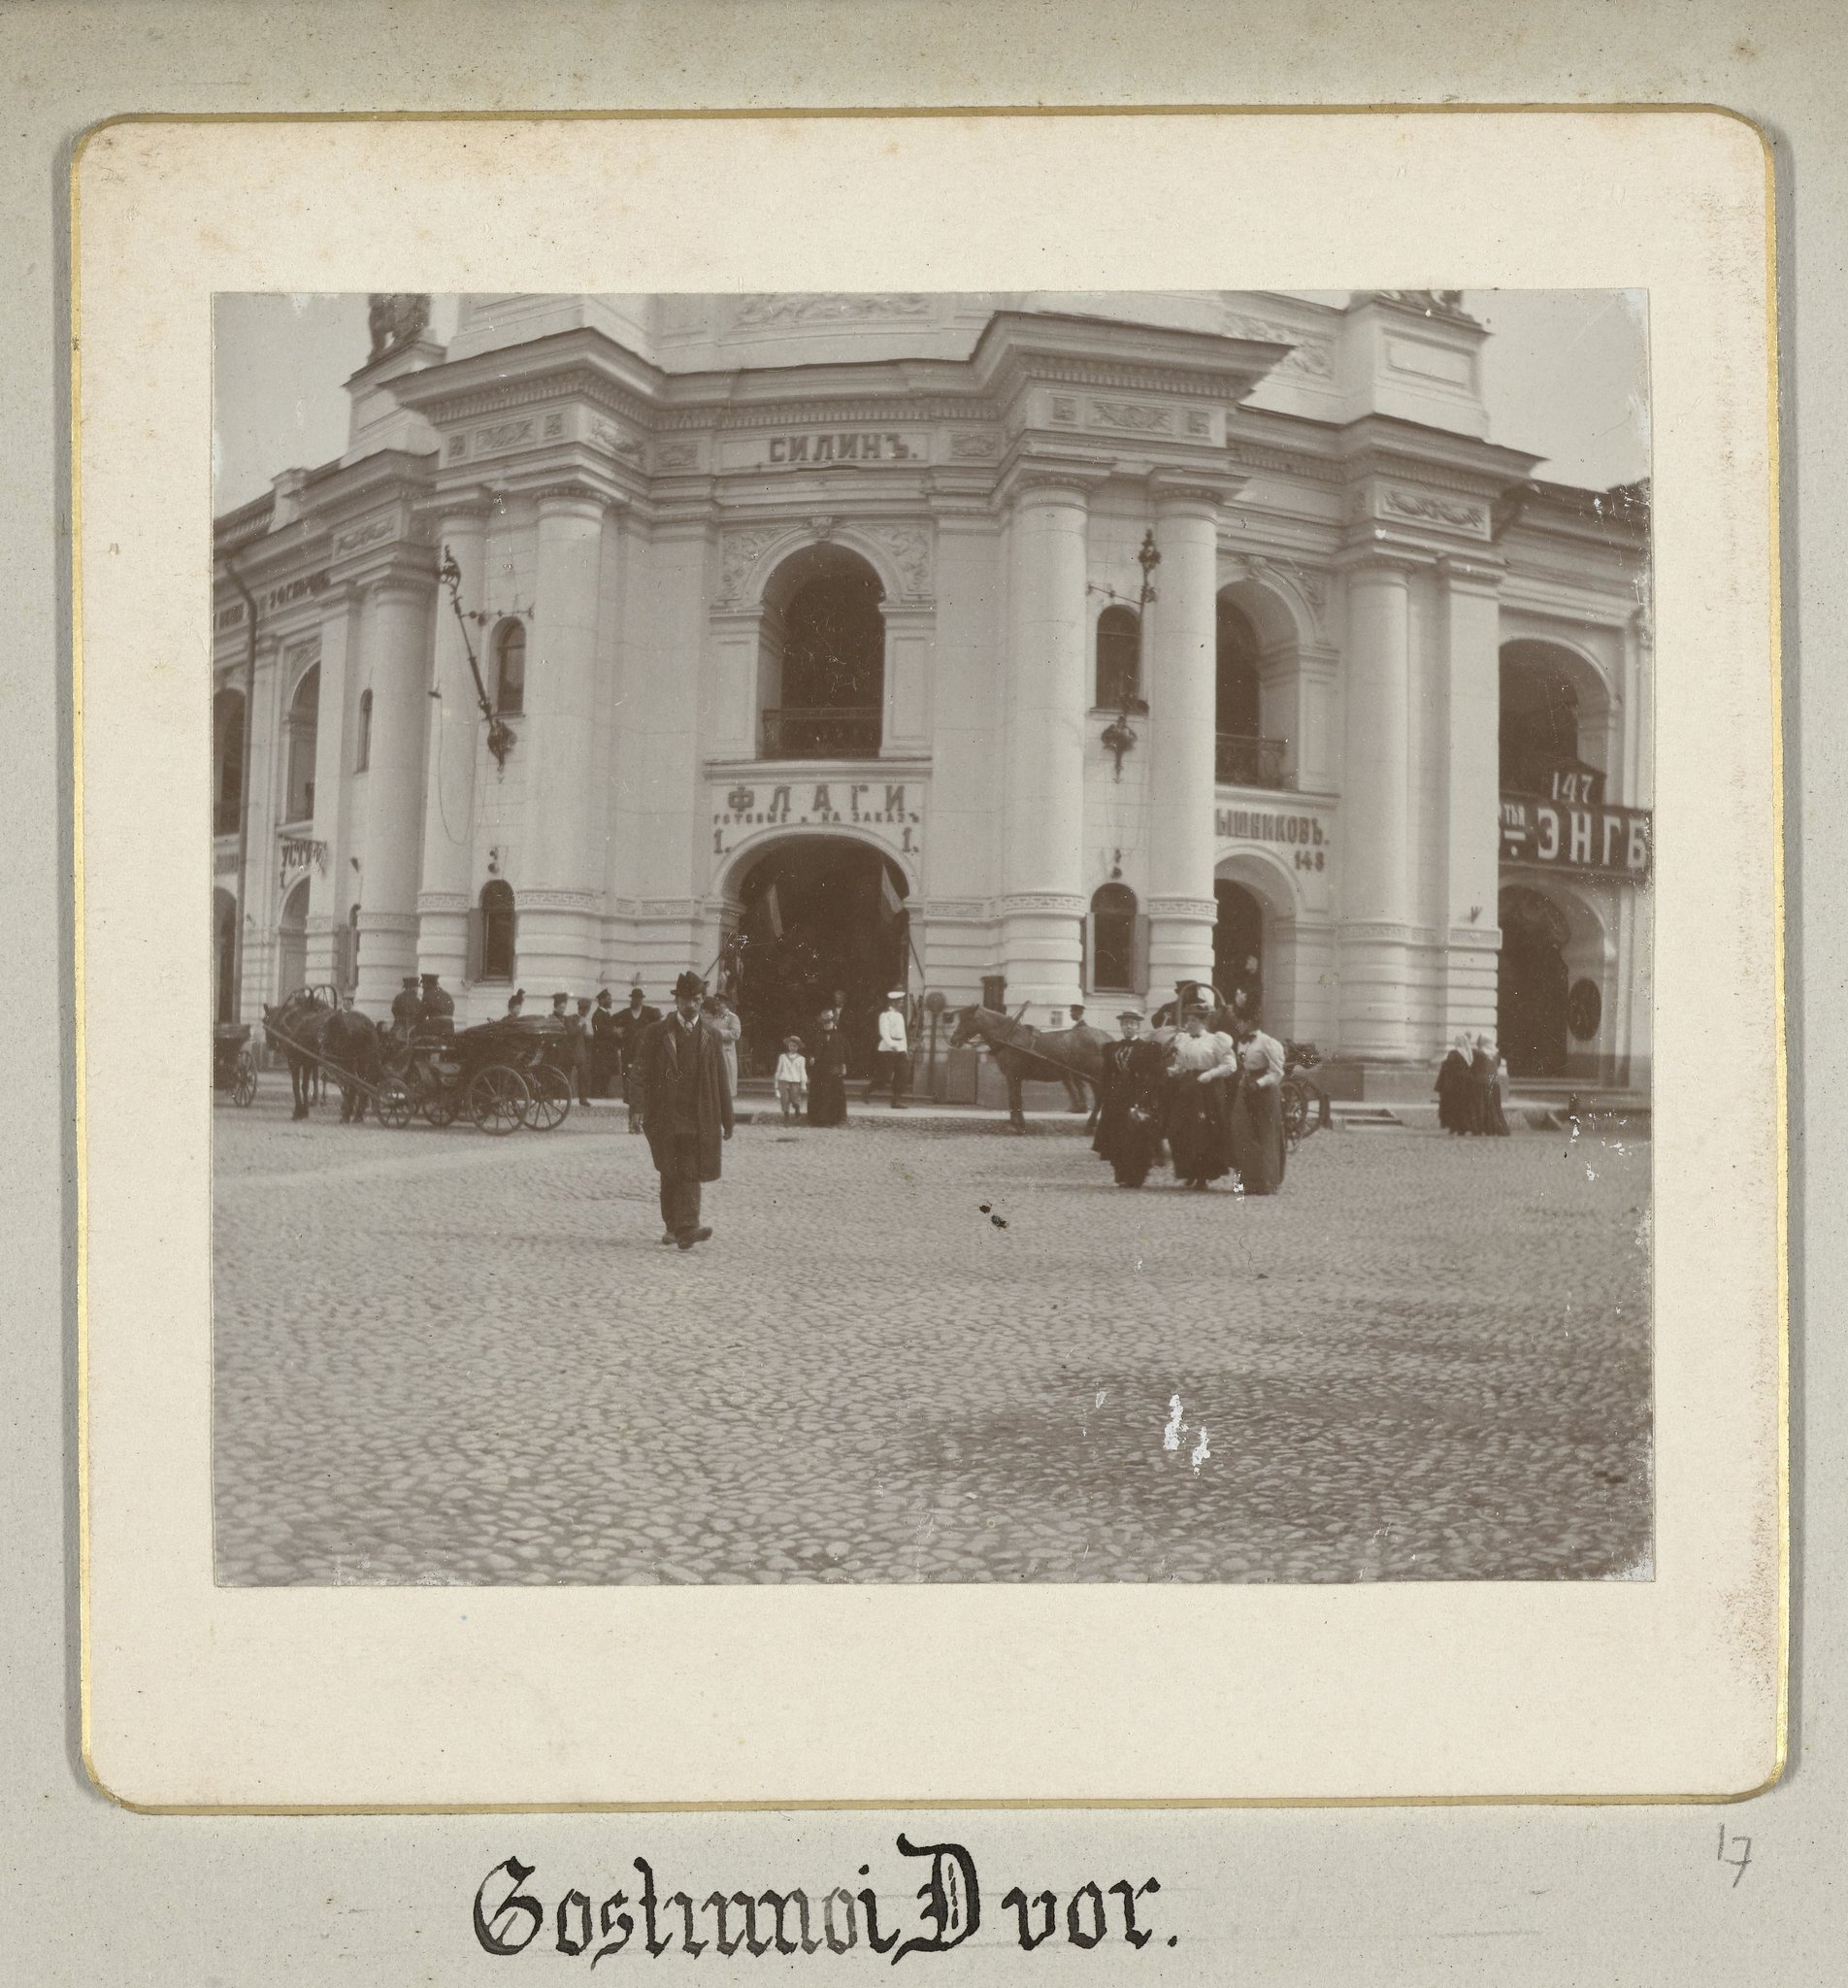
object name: photograph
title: Gezicht op een van de ingangen van het 18de-eeuws warenhuis Gostiny Dvor op de Nevski Prospekt in Sint Petersburg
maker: henry pauw van wieldrecht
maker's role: fotograaf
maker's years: 1863-1912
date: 1898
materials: paper, photographic support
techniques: albumen print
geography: netherlands